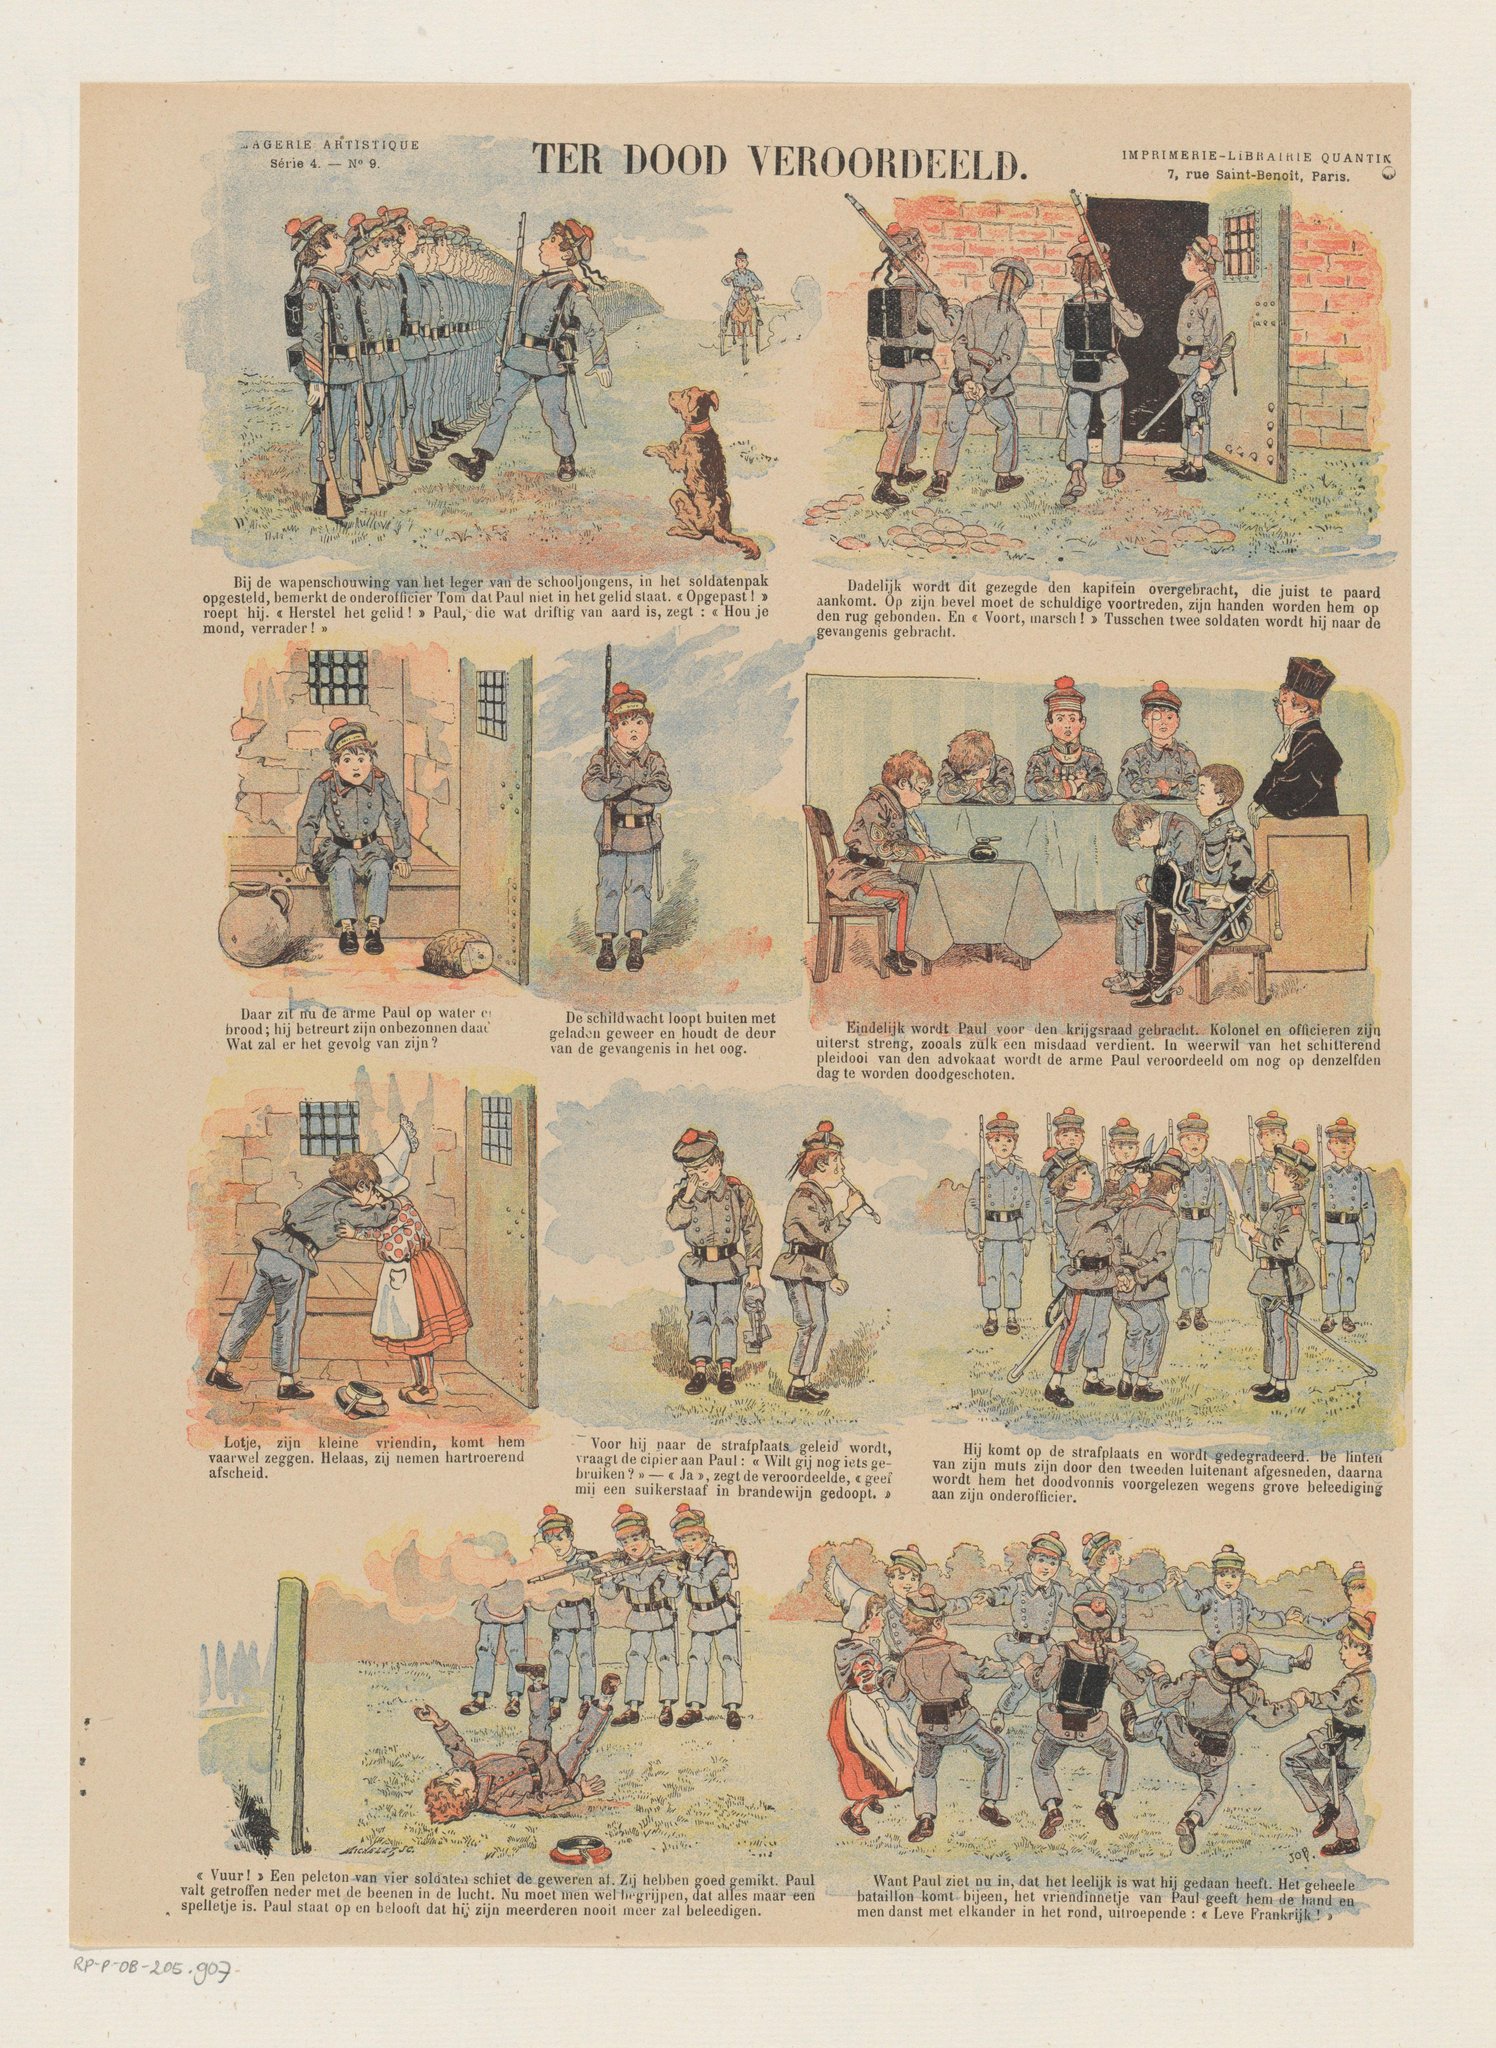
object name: popular print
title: Imagerie Artistique / Série 4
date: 1876-1890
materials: paper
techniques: lithograph, letterpress printing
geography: paris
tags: children's games and plays, tales and fairy tales, the soldier; the soldier's life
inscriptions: collector's mark: Lugt 2760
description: Blad met 9 voorstellingen van kinderen die soldaatje spelen. Onder elke voorstelling een onderschrift. Genummerd linksboven: Série 4. - No. 9.